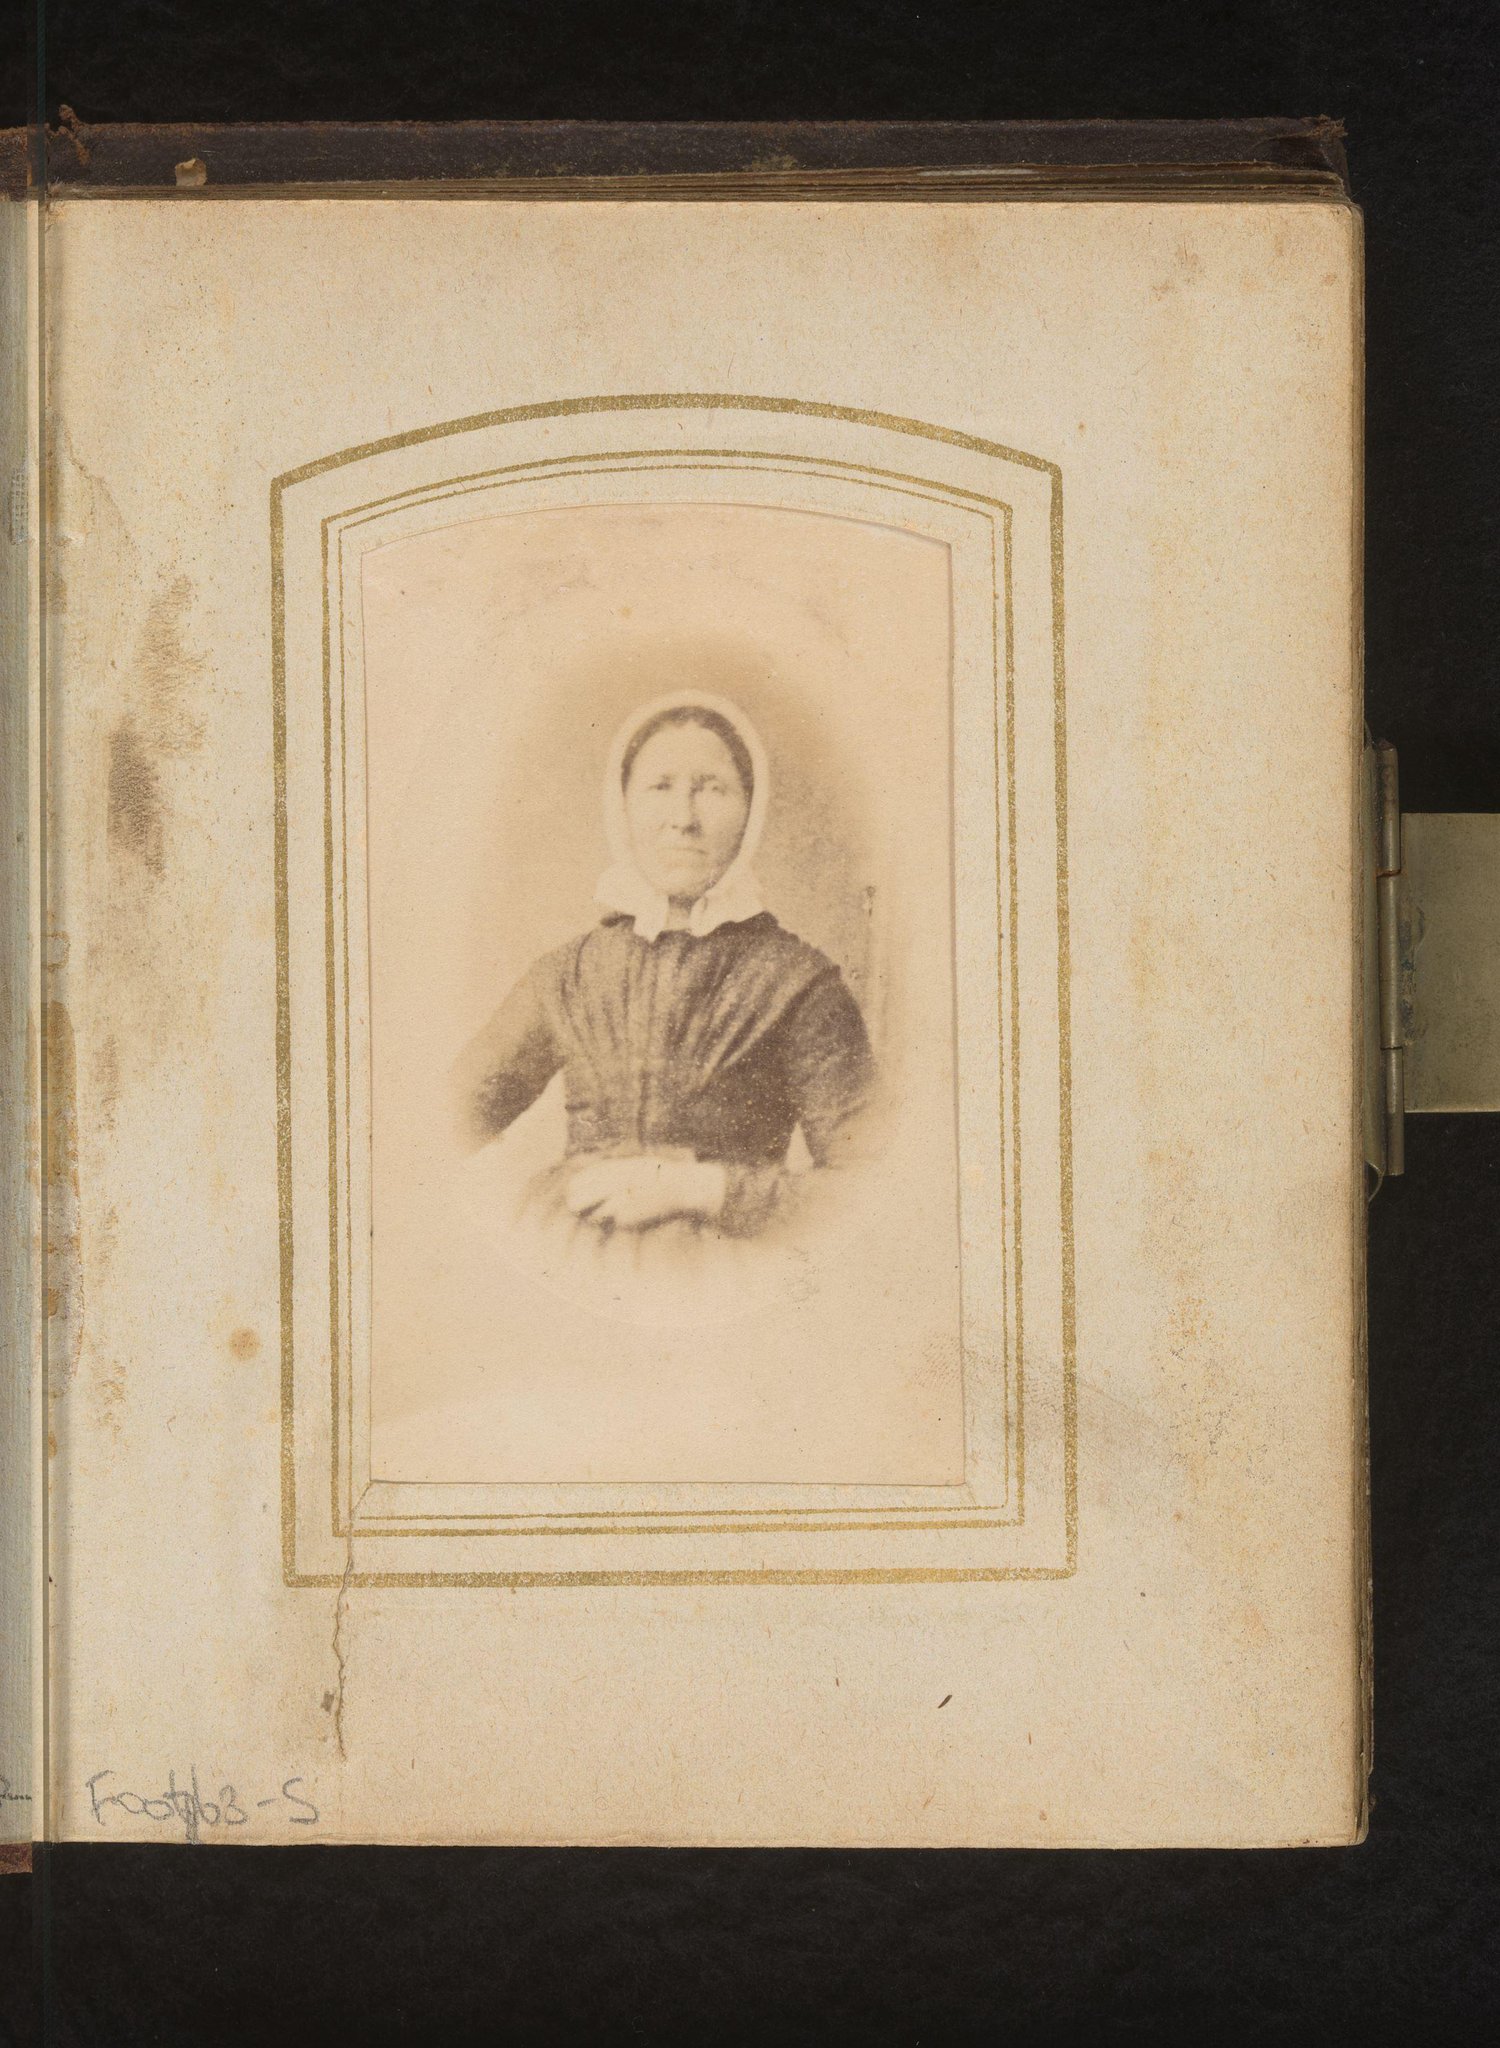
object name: carte de visite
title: Portret van een vrouw met witte klederdrachtmuts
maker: simon van caspel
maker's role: fotograaf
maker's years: 1843-1880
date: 1867-1880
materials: cardboard, photographic support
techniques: albumen print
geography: amsterdam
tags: historical persons - bb - woman, head-gear: cap, folk costume, regional costume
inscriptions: inscription: ‘PHOTOGRAPHISCH ETABLISSEMENT/ van/ S. van CASPEL/ Wolvenstraat K K. 19./ AMSTERDAM’